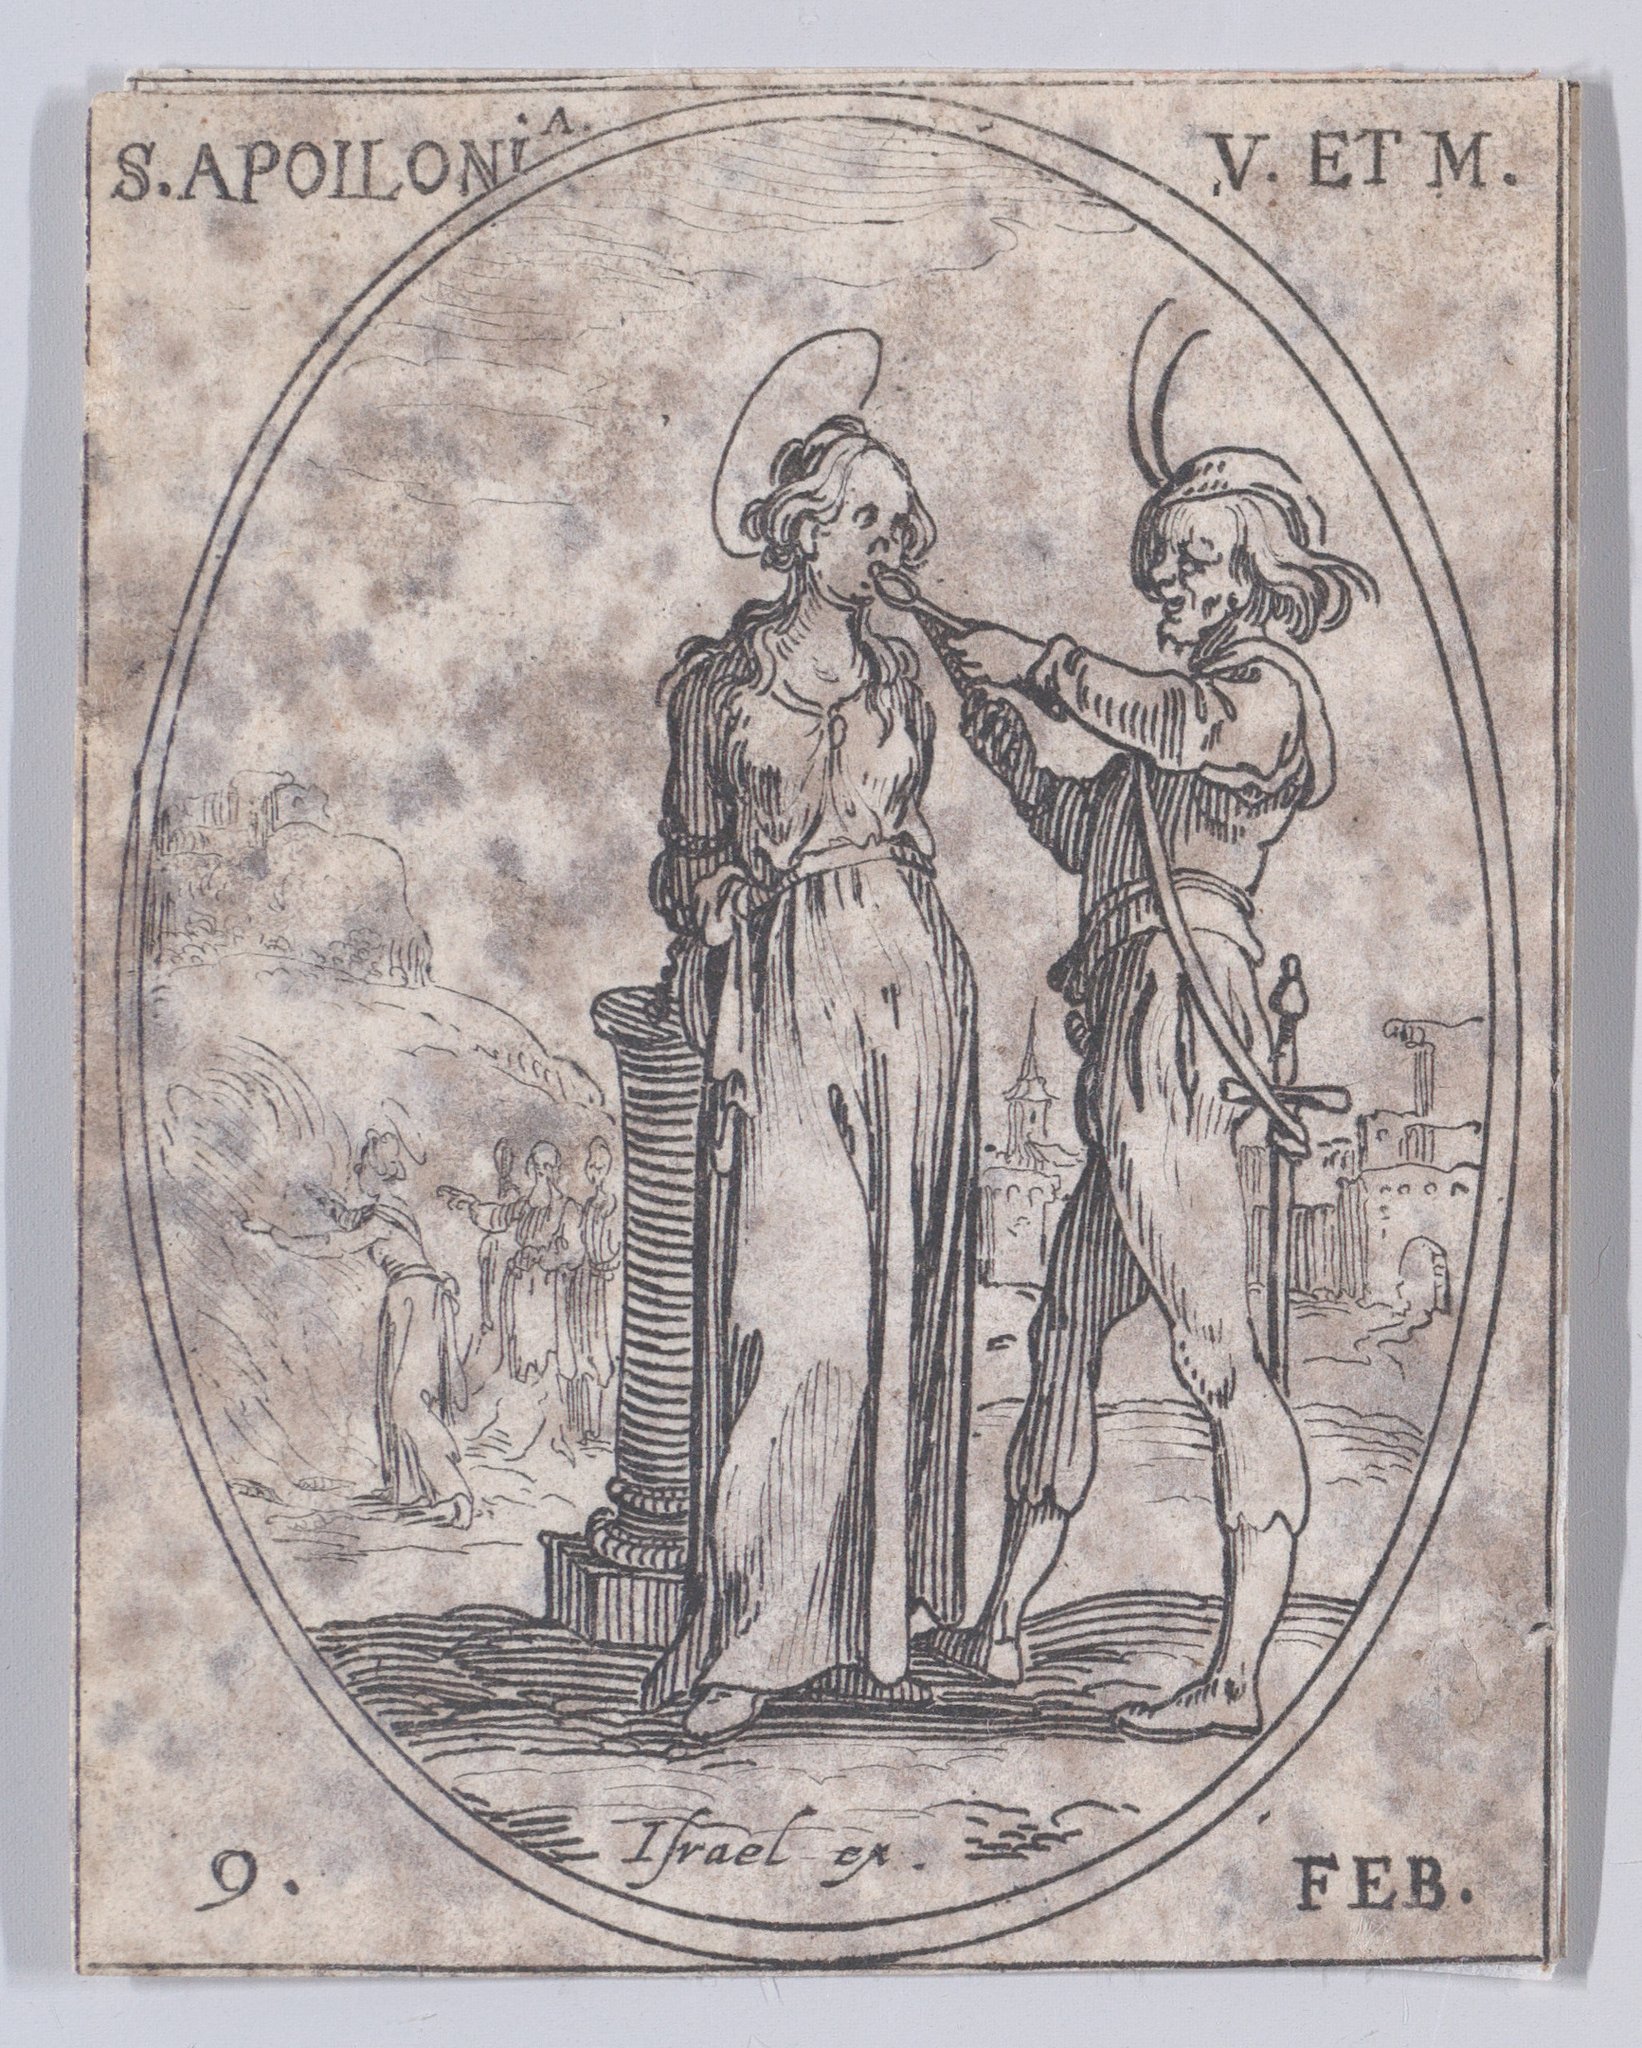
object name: print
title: S. Apolline, vierge et martyre (St. Apollonia, Virgin and Martyr), February 9th, from "Les Images De Tous Les Saincts et Saintes de L'Année" (Images of All of the Saints and Feast Days of the Year)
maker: jacques callot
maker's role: artist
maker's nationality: french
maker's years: 1592-1635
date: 1636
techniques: etching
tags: men,women,saints